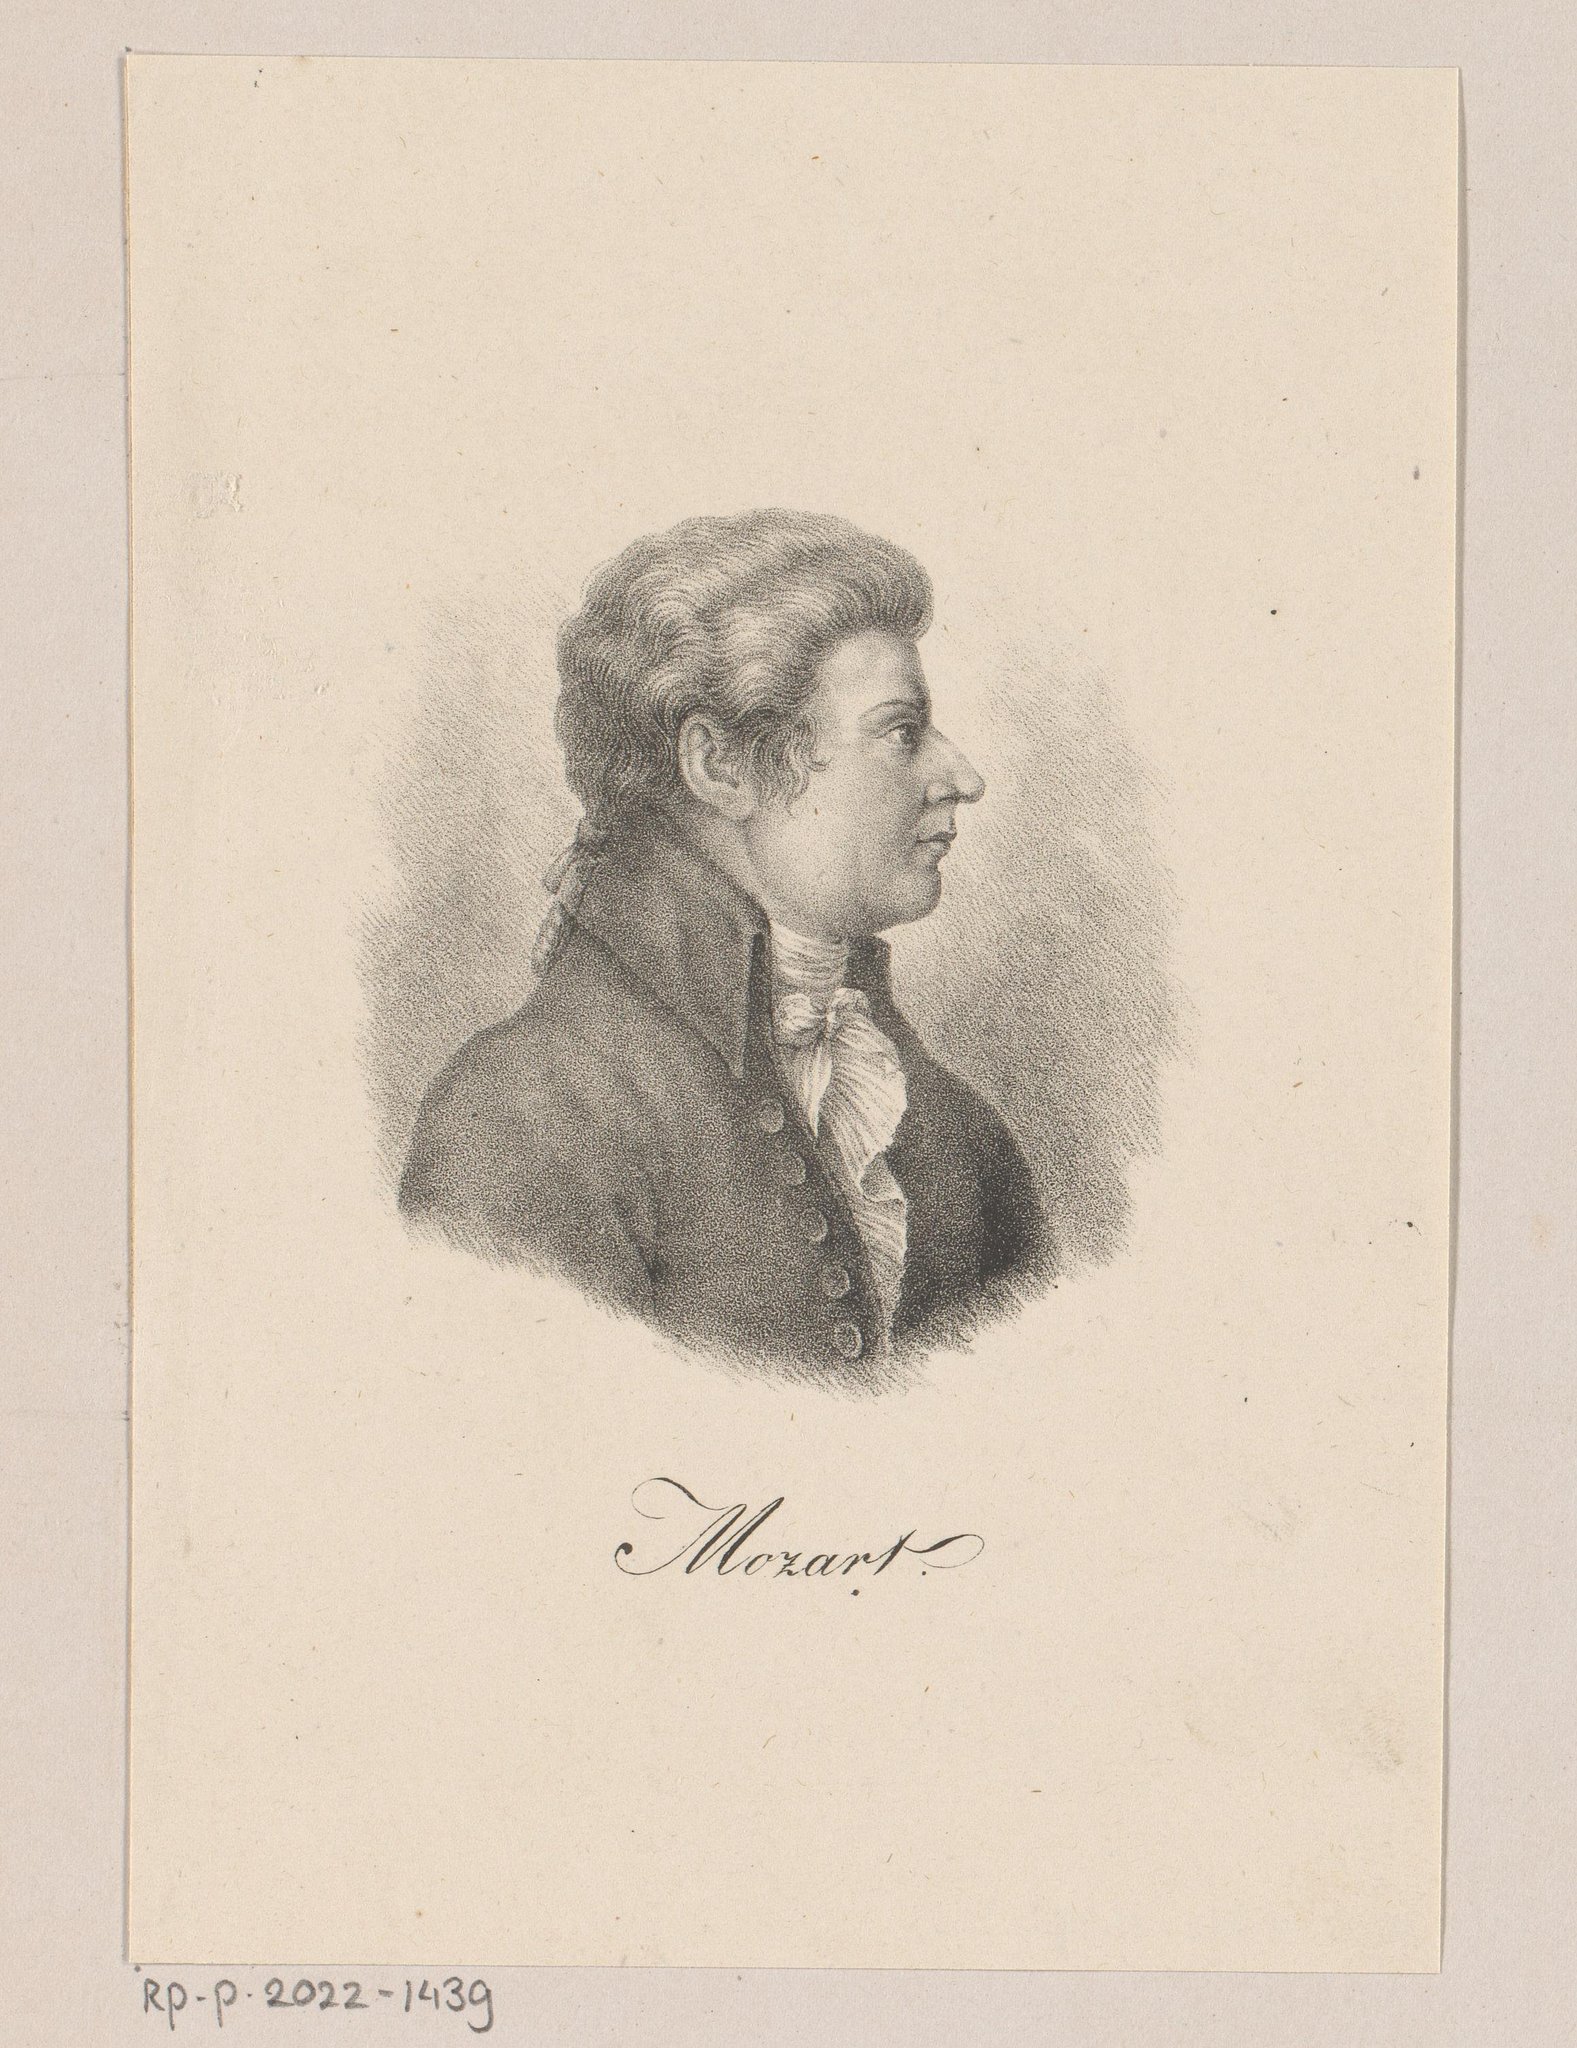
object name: print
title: Portret van Wolfgang Amadeus Mozart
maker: Anonymous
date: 1800-1900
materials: paper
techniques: lithograph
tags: vienna, historical persons, portrait of composer